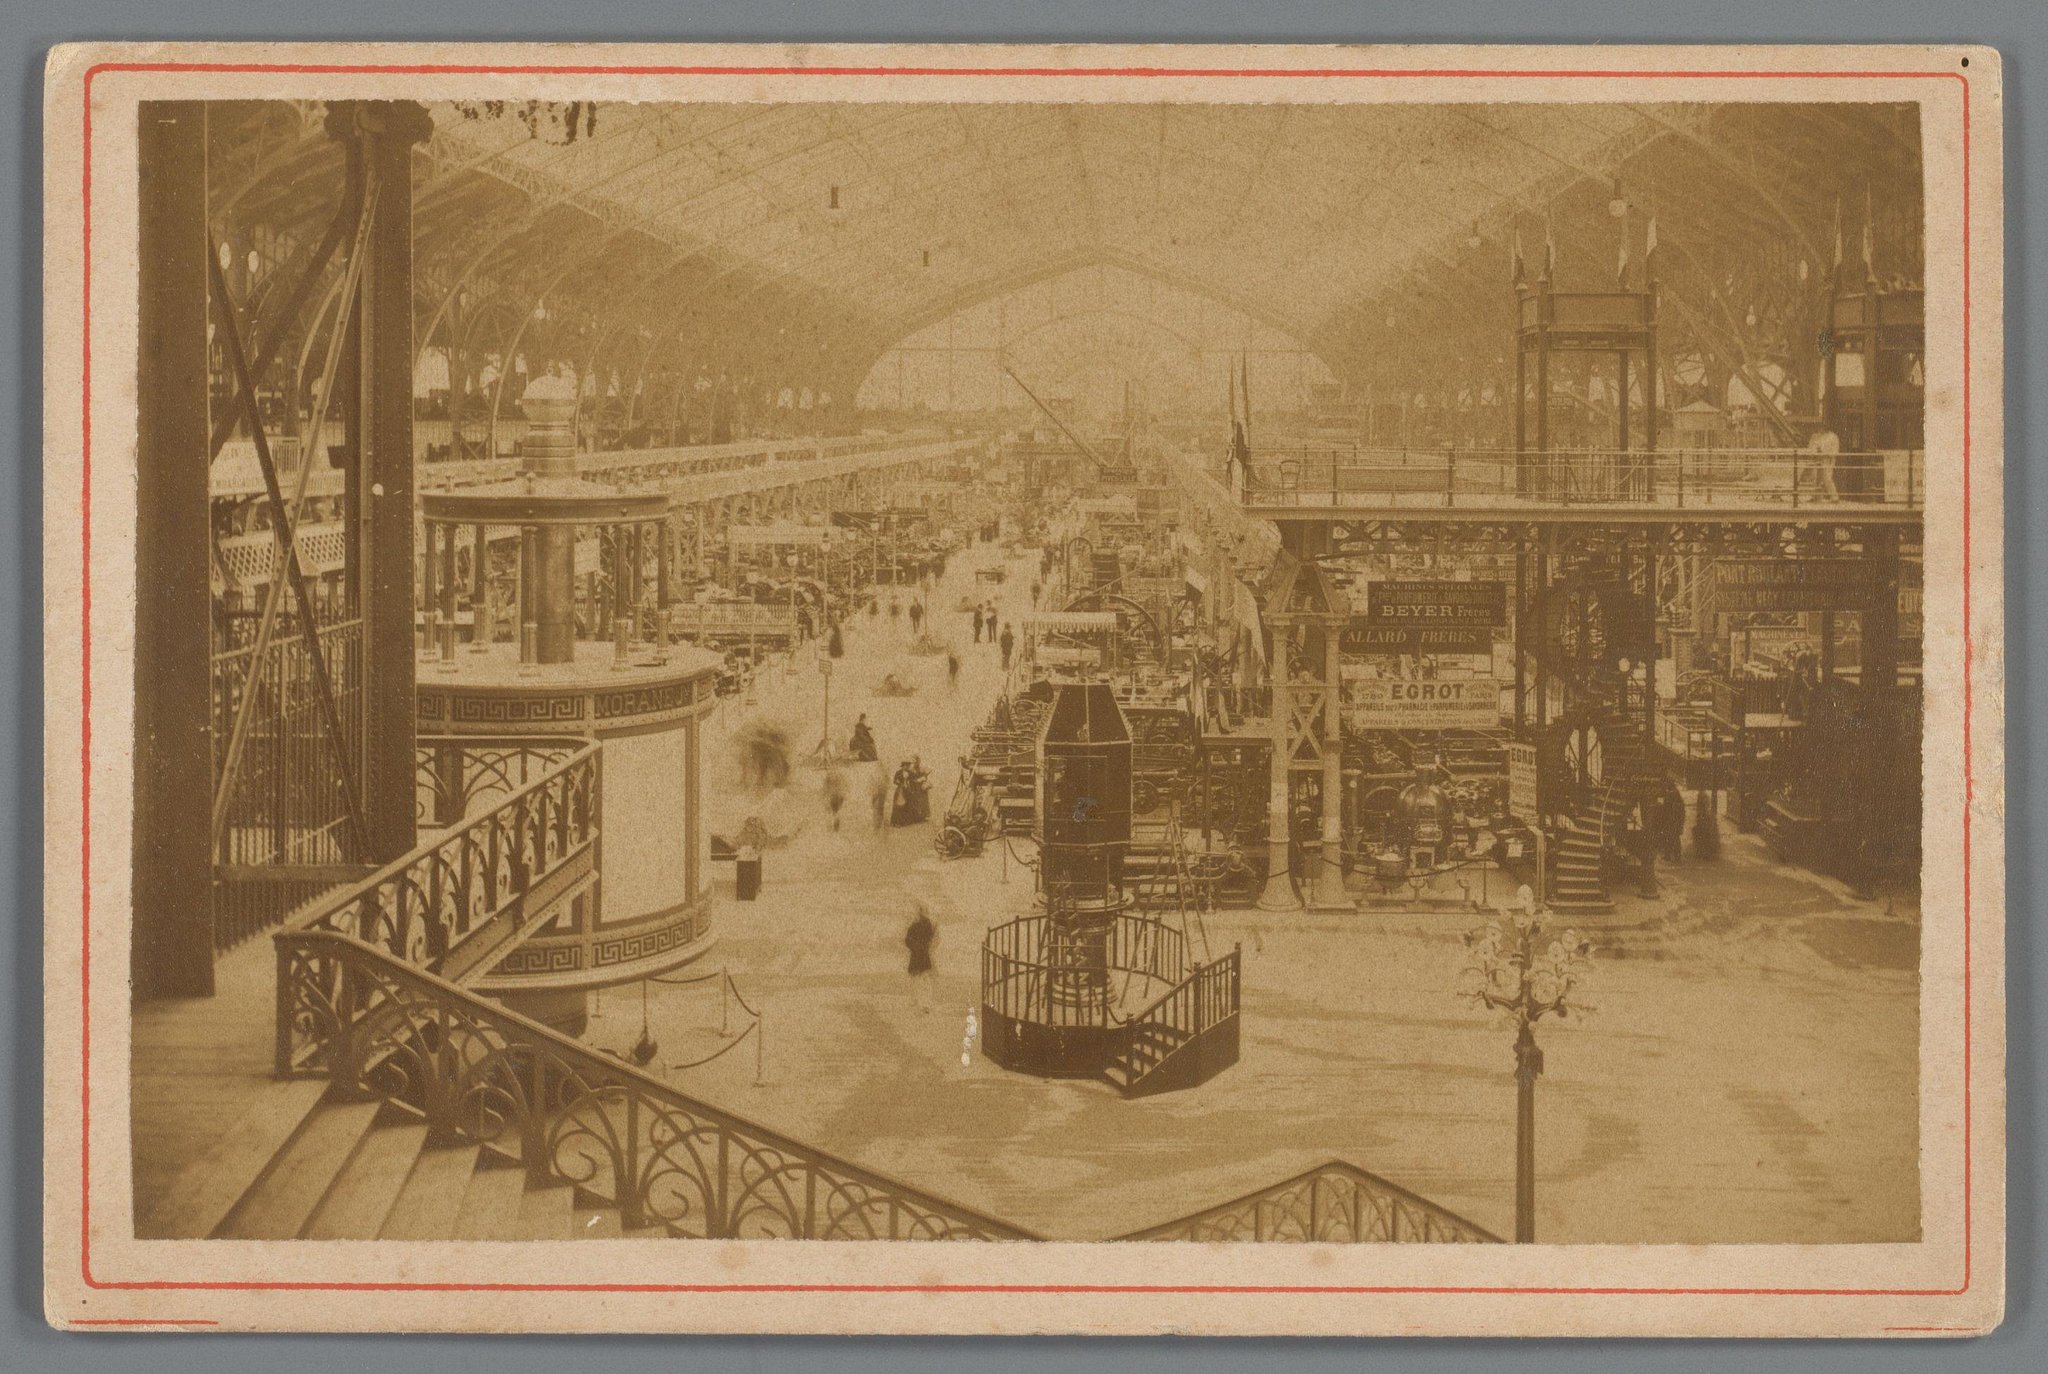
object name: photograph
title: Interieur van de machinehal tijdens de Wereldtentoonstelling van 1889 in Parijs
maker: Anonymous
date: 1889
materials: cardboard, paper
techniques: albumen print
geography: paris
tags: world fair, world exhibition, machines, engines ~ crafts and industries, paris